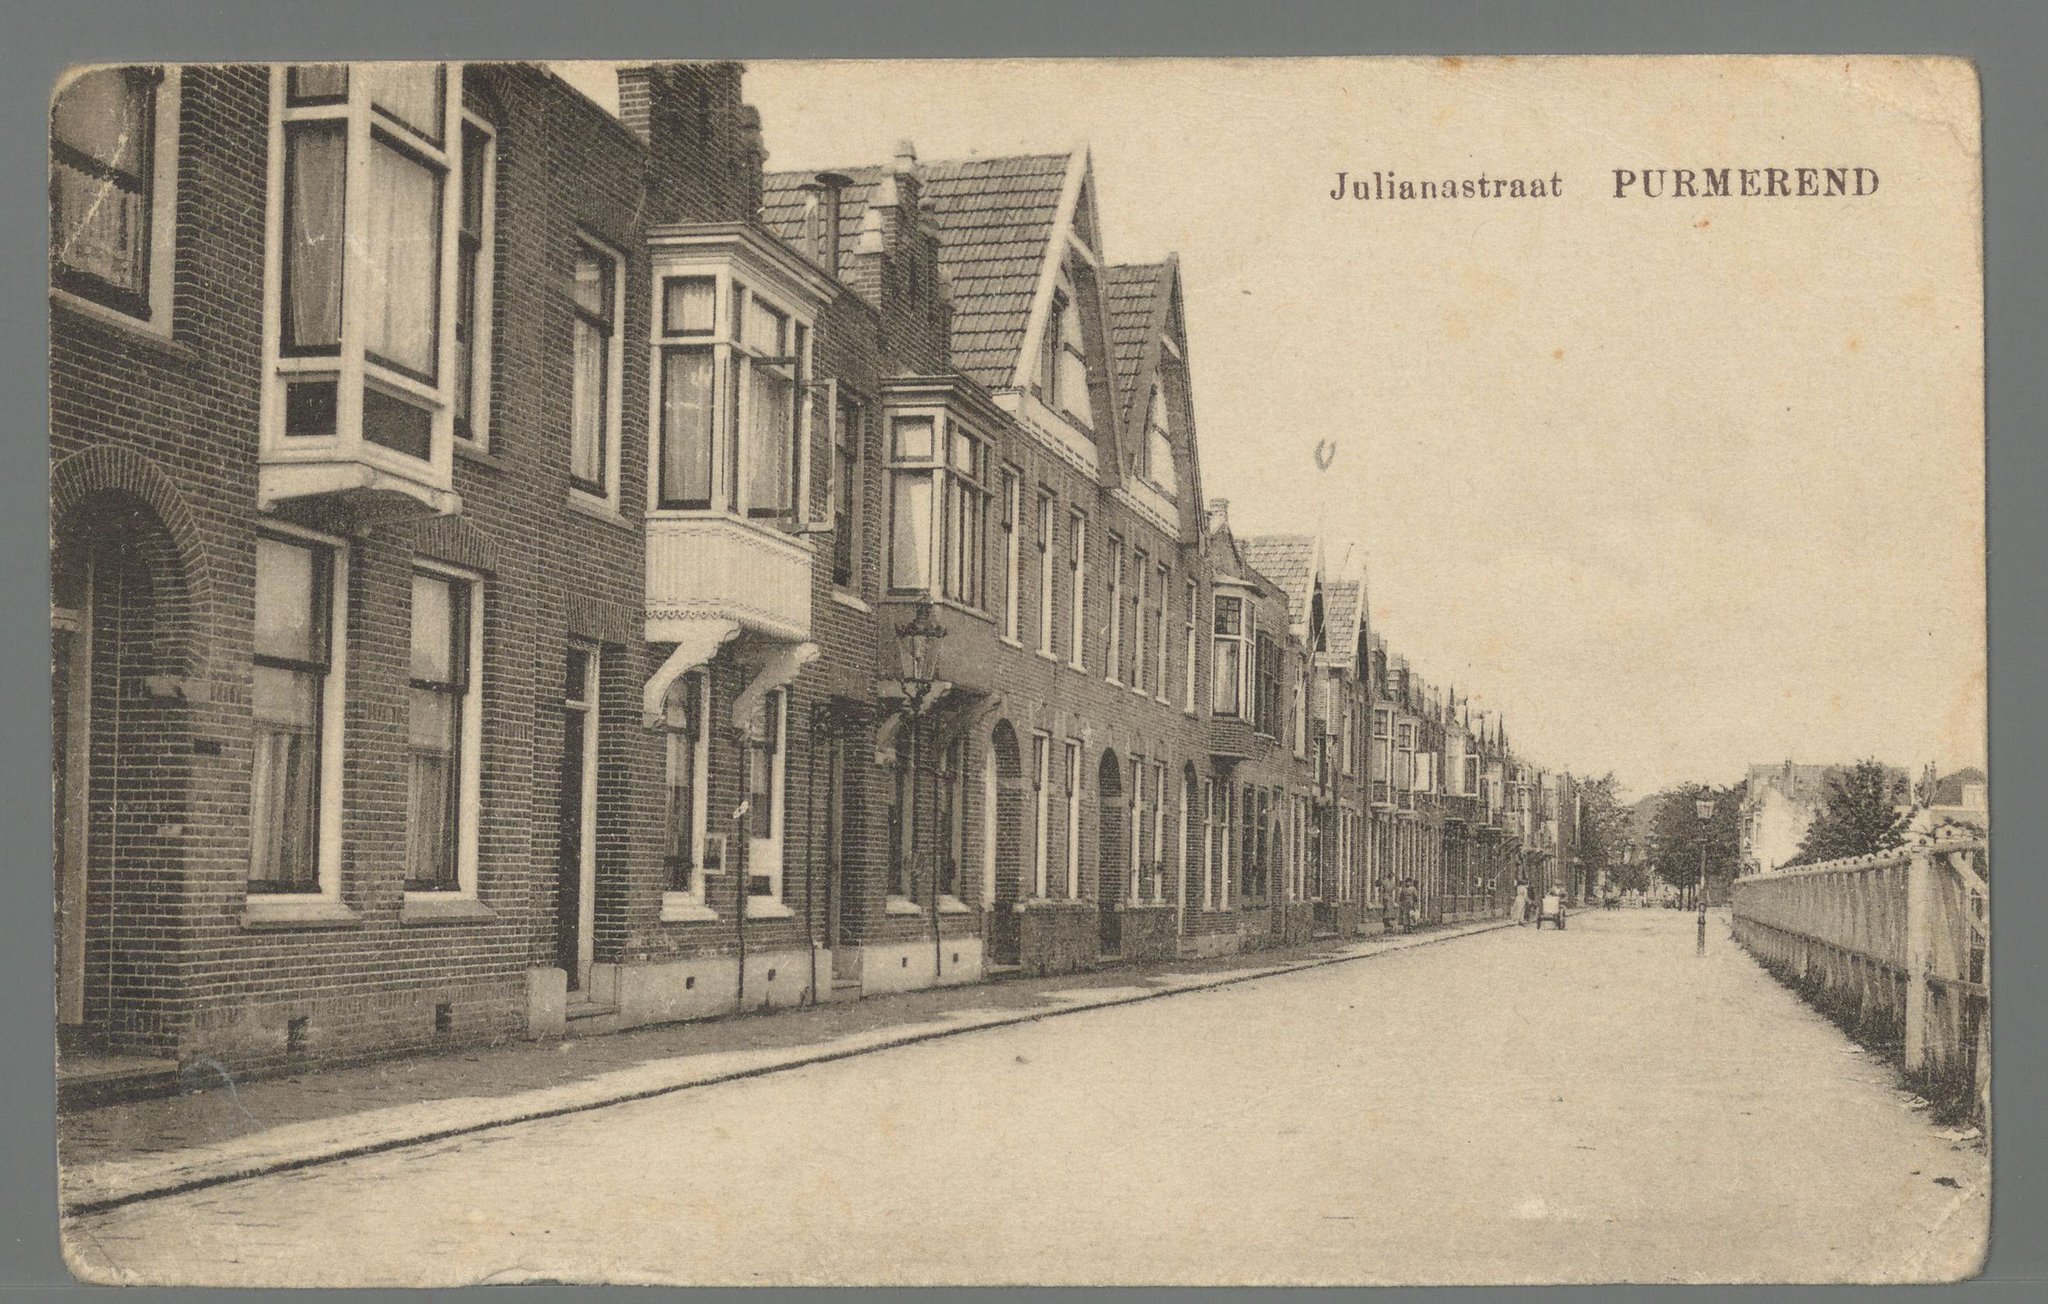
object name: photomechanical print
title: Julianastraat Purmerend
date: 1905-1930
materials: cardboard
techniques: photograph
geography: purmerend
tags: village street